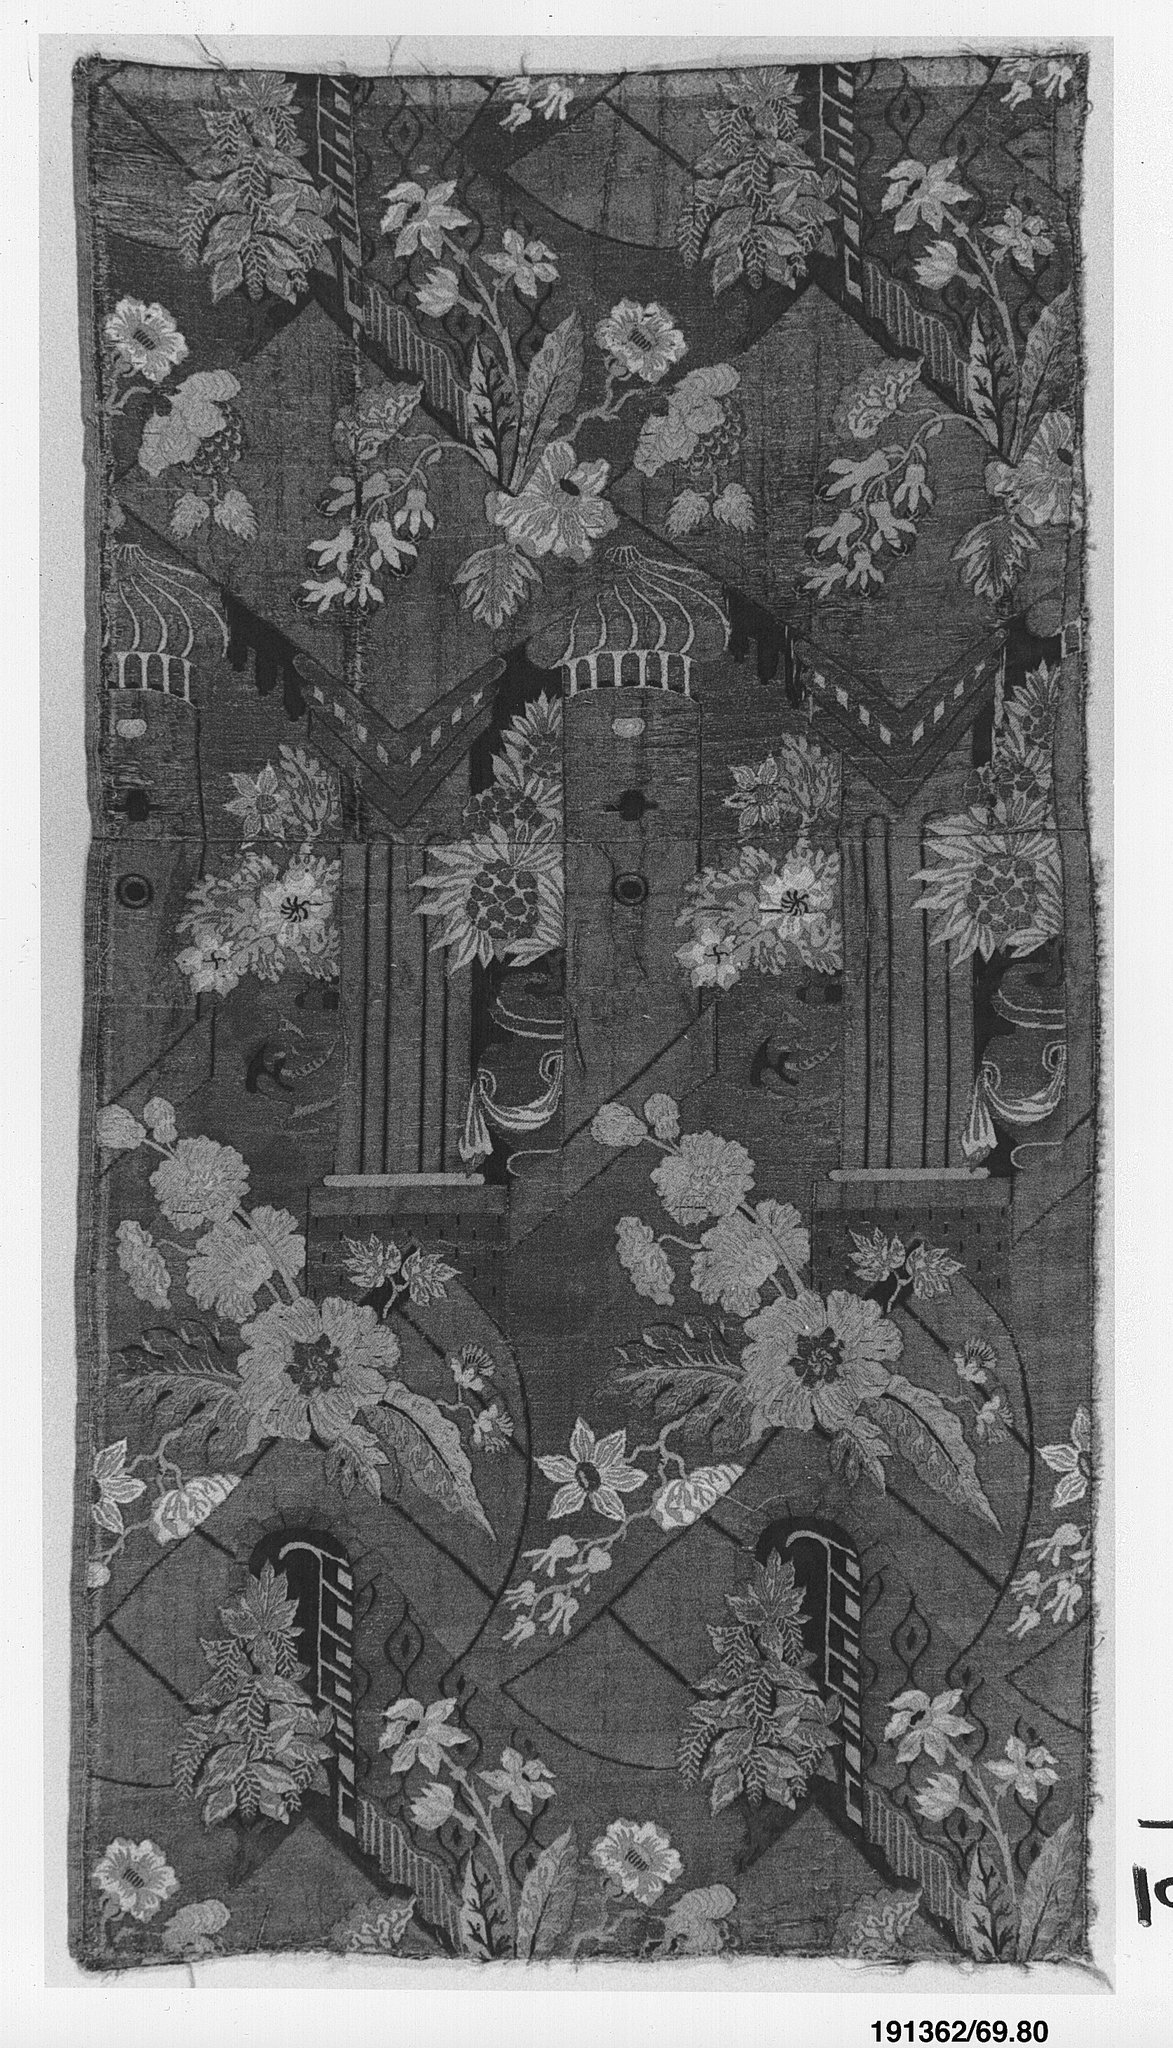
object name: length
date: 1667-1733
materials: metal thread, silk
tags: flowers